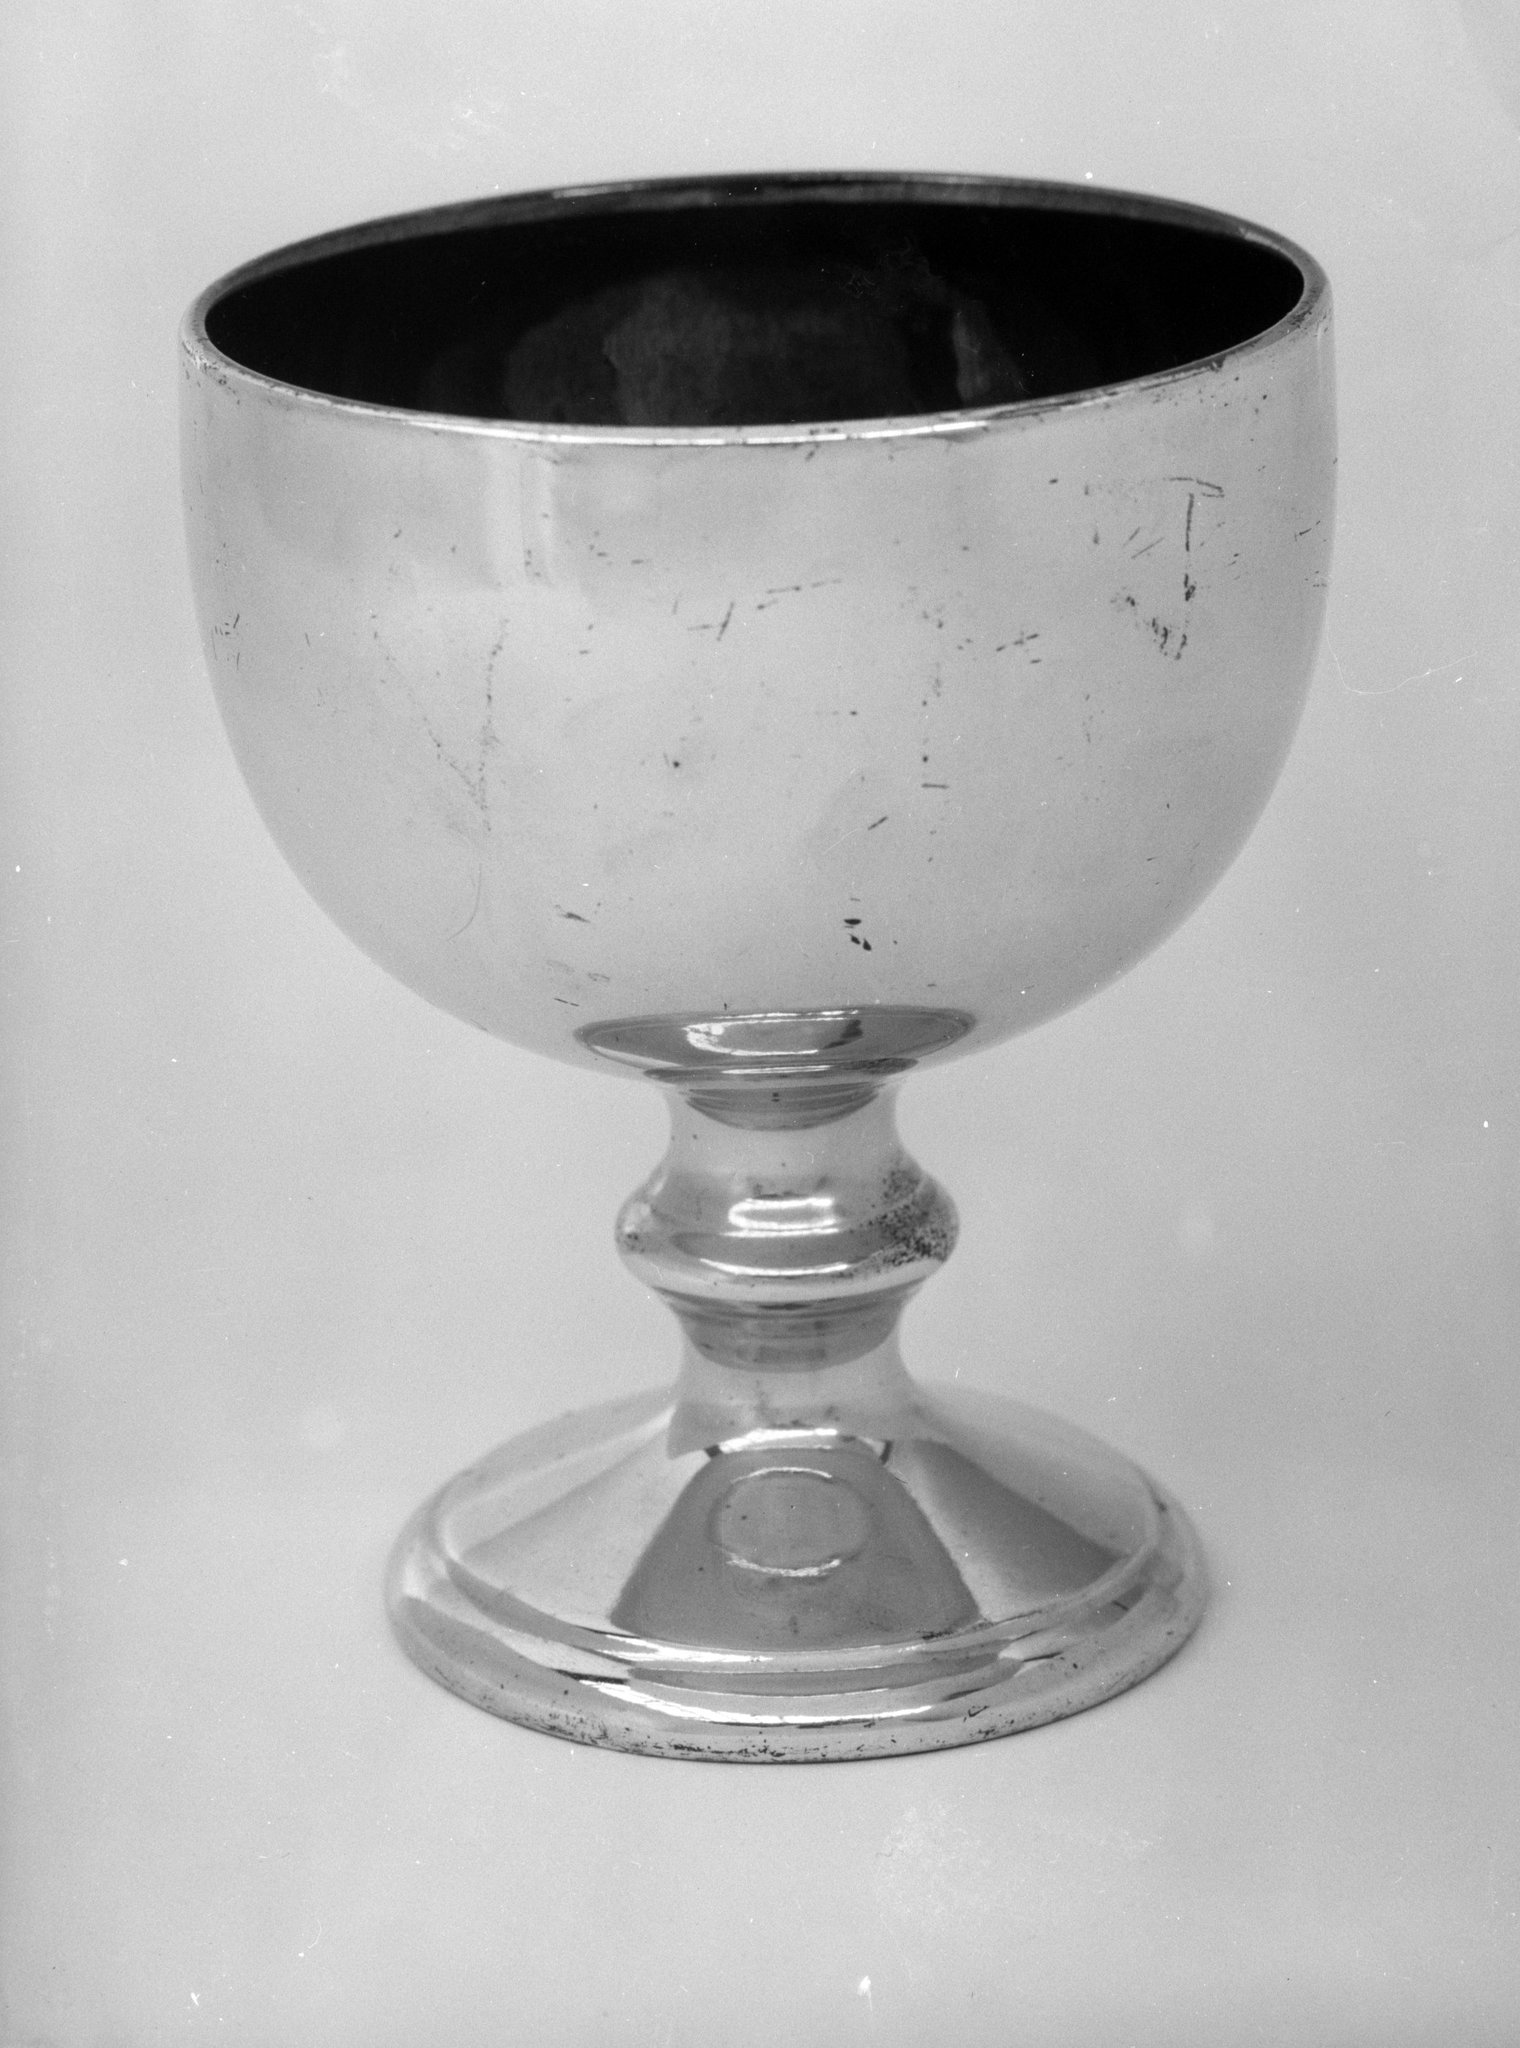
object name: goblet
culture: british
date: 1800-1830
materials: earthenware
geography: england